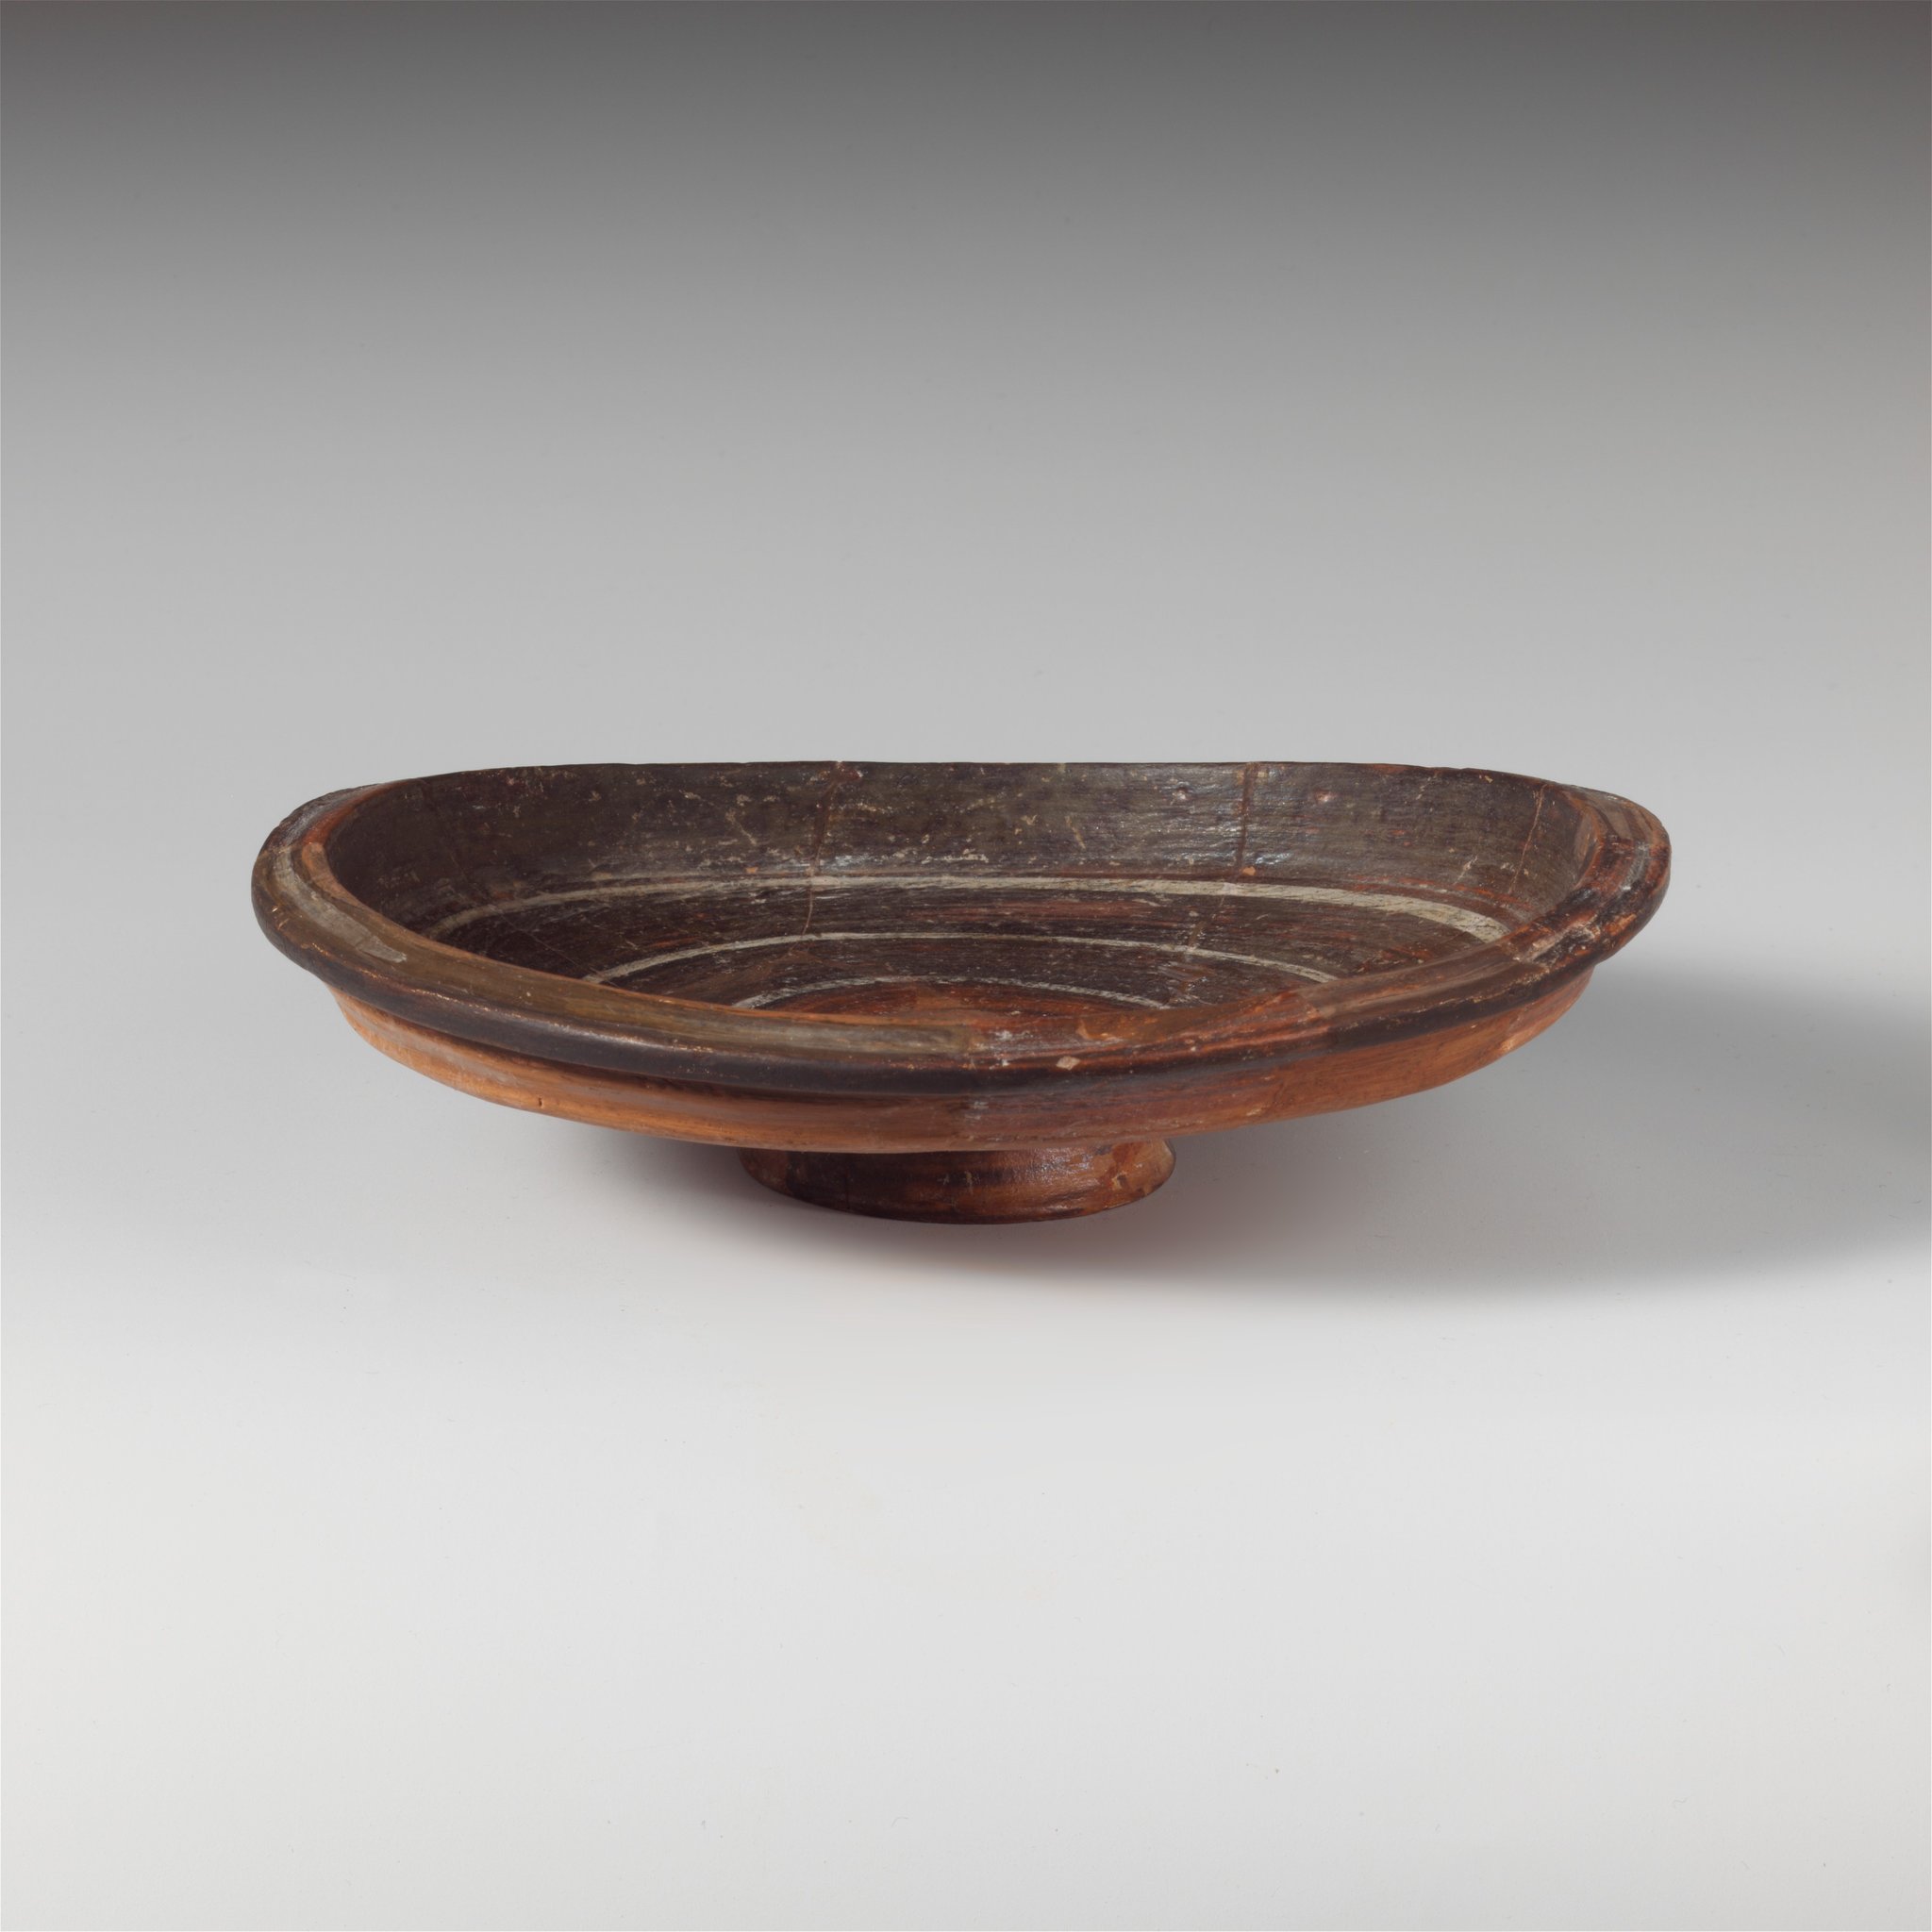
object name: bowl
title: Shallow terracotta bowl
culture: lydian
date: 600-501 BCE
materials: terracotta